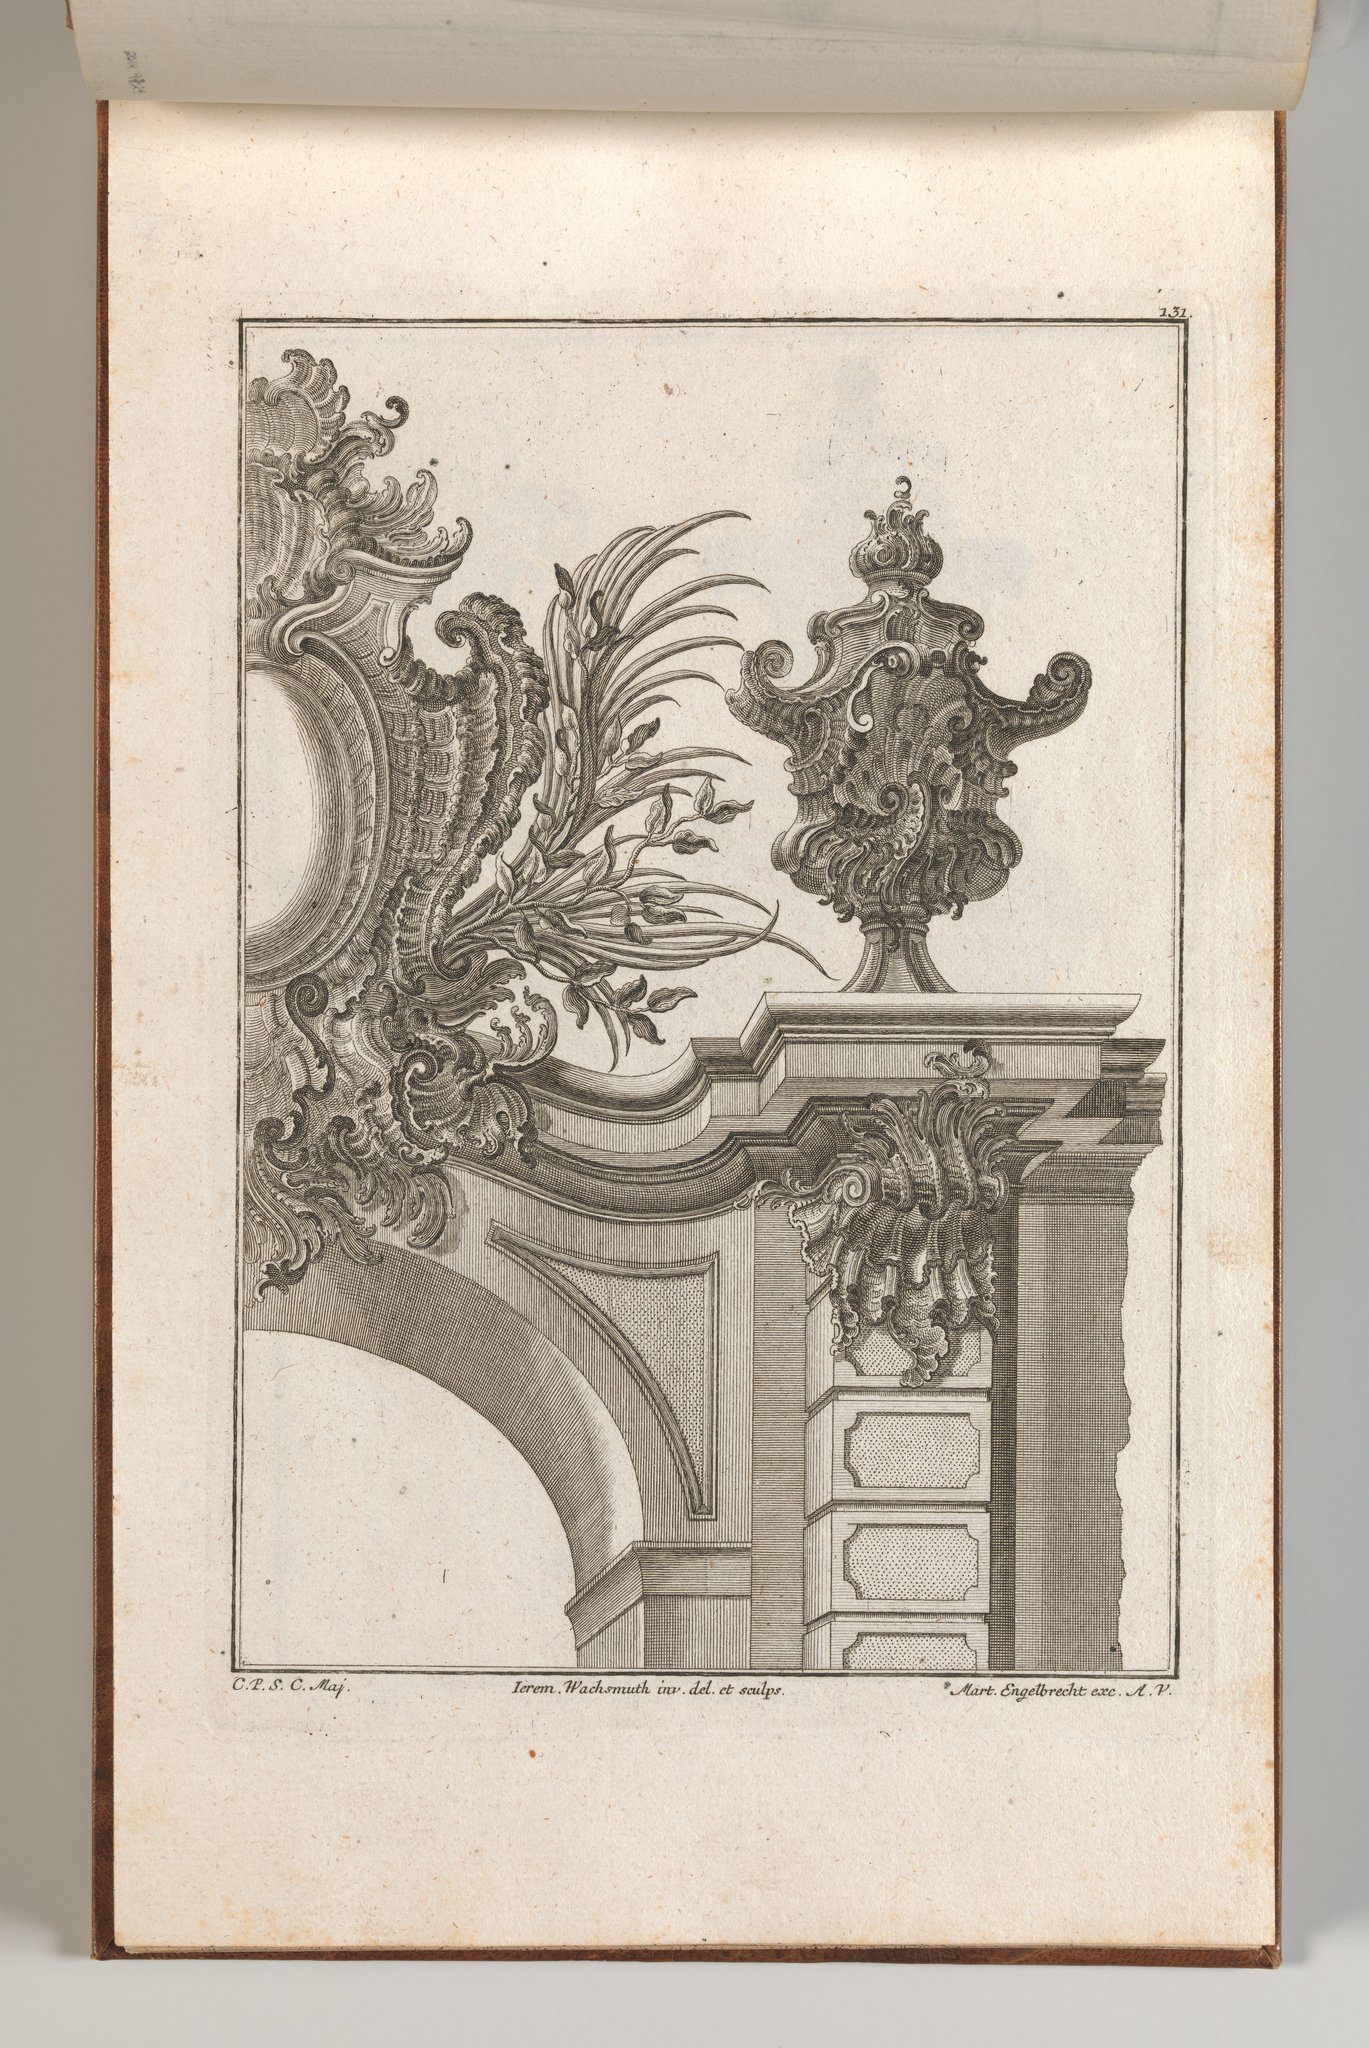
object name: album print ornament architecture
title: Suggestion for the Decoration of Top Right Side of Portal, Plate 3 from 'Allerneueste Façon von Auszierungen zu Portalen'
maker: jeremias wachsmuth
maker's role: artist and engraver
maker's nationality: german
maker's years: 1712-1771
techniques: etching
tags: ornament